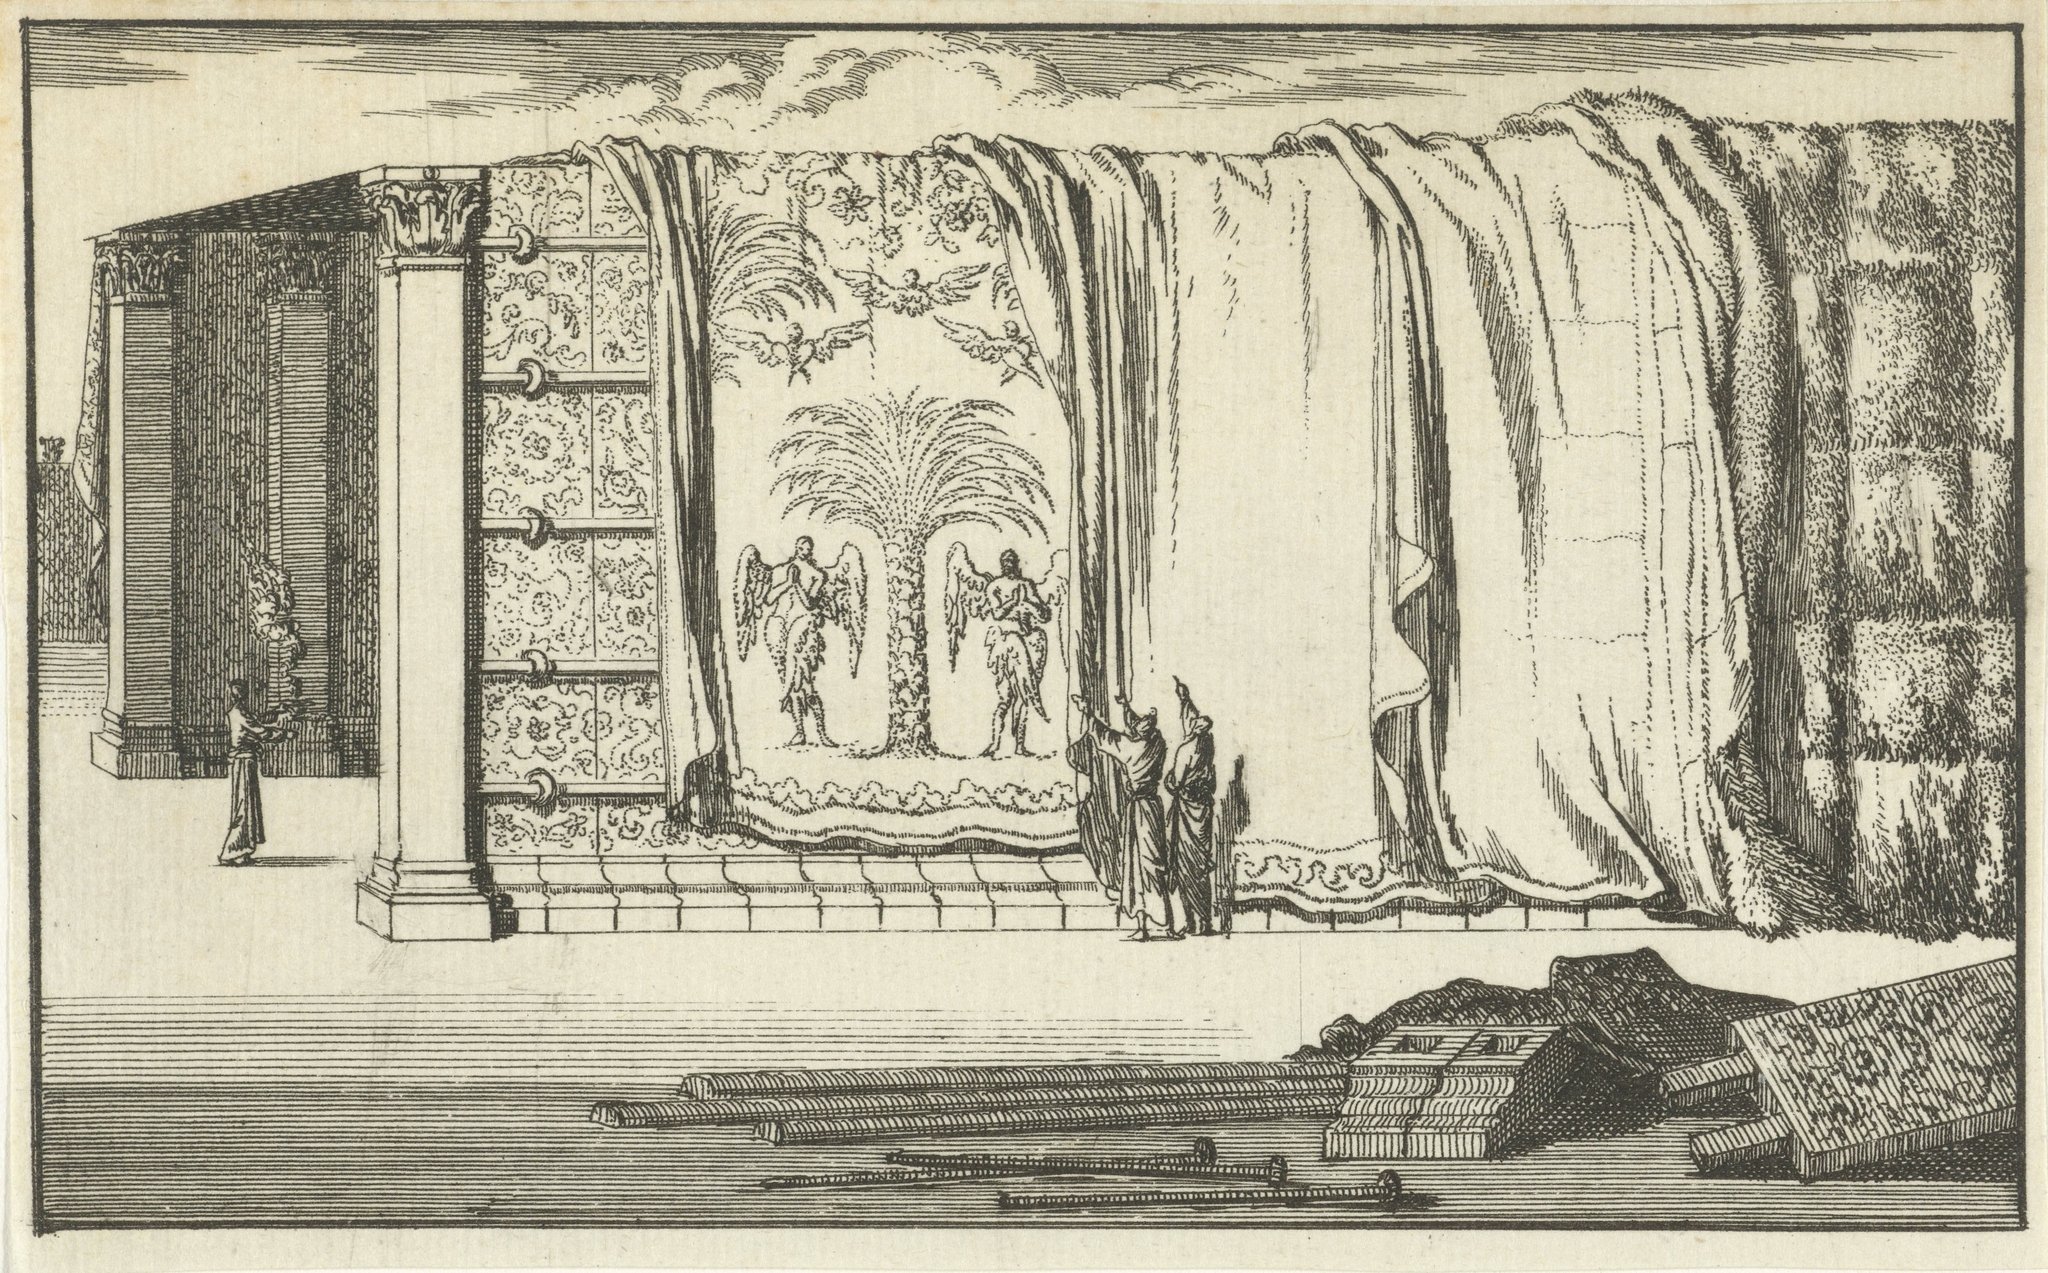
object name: print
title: Bouw van de tabernakel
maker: Anonymous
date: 1683-1762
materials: paper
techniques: etching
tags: the making of the tabernacle and its accessories ~ exodus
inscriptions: collector's mark: Lugt 2228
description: Origineel opgenomen in: Cunaeus, Petrus. De republyk der Hebreen, of gemeenebest der joden, 3 delen. Amsterdam: Wilhelmus Goeree, 1683, dl. 2, p. 476.